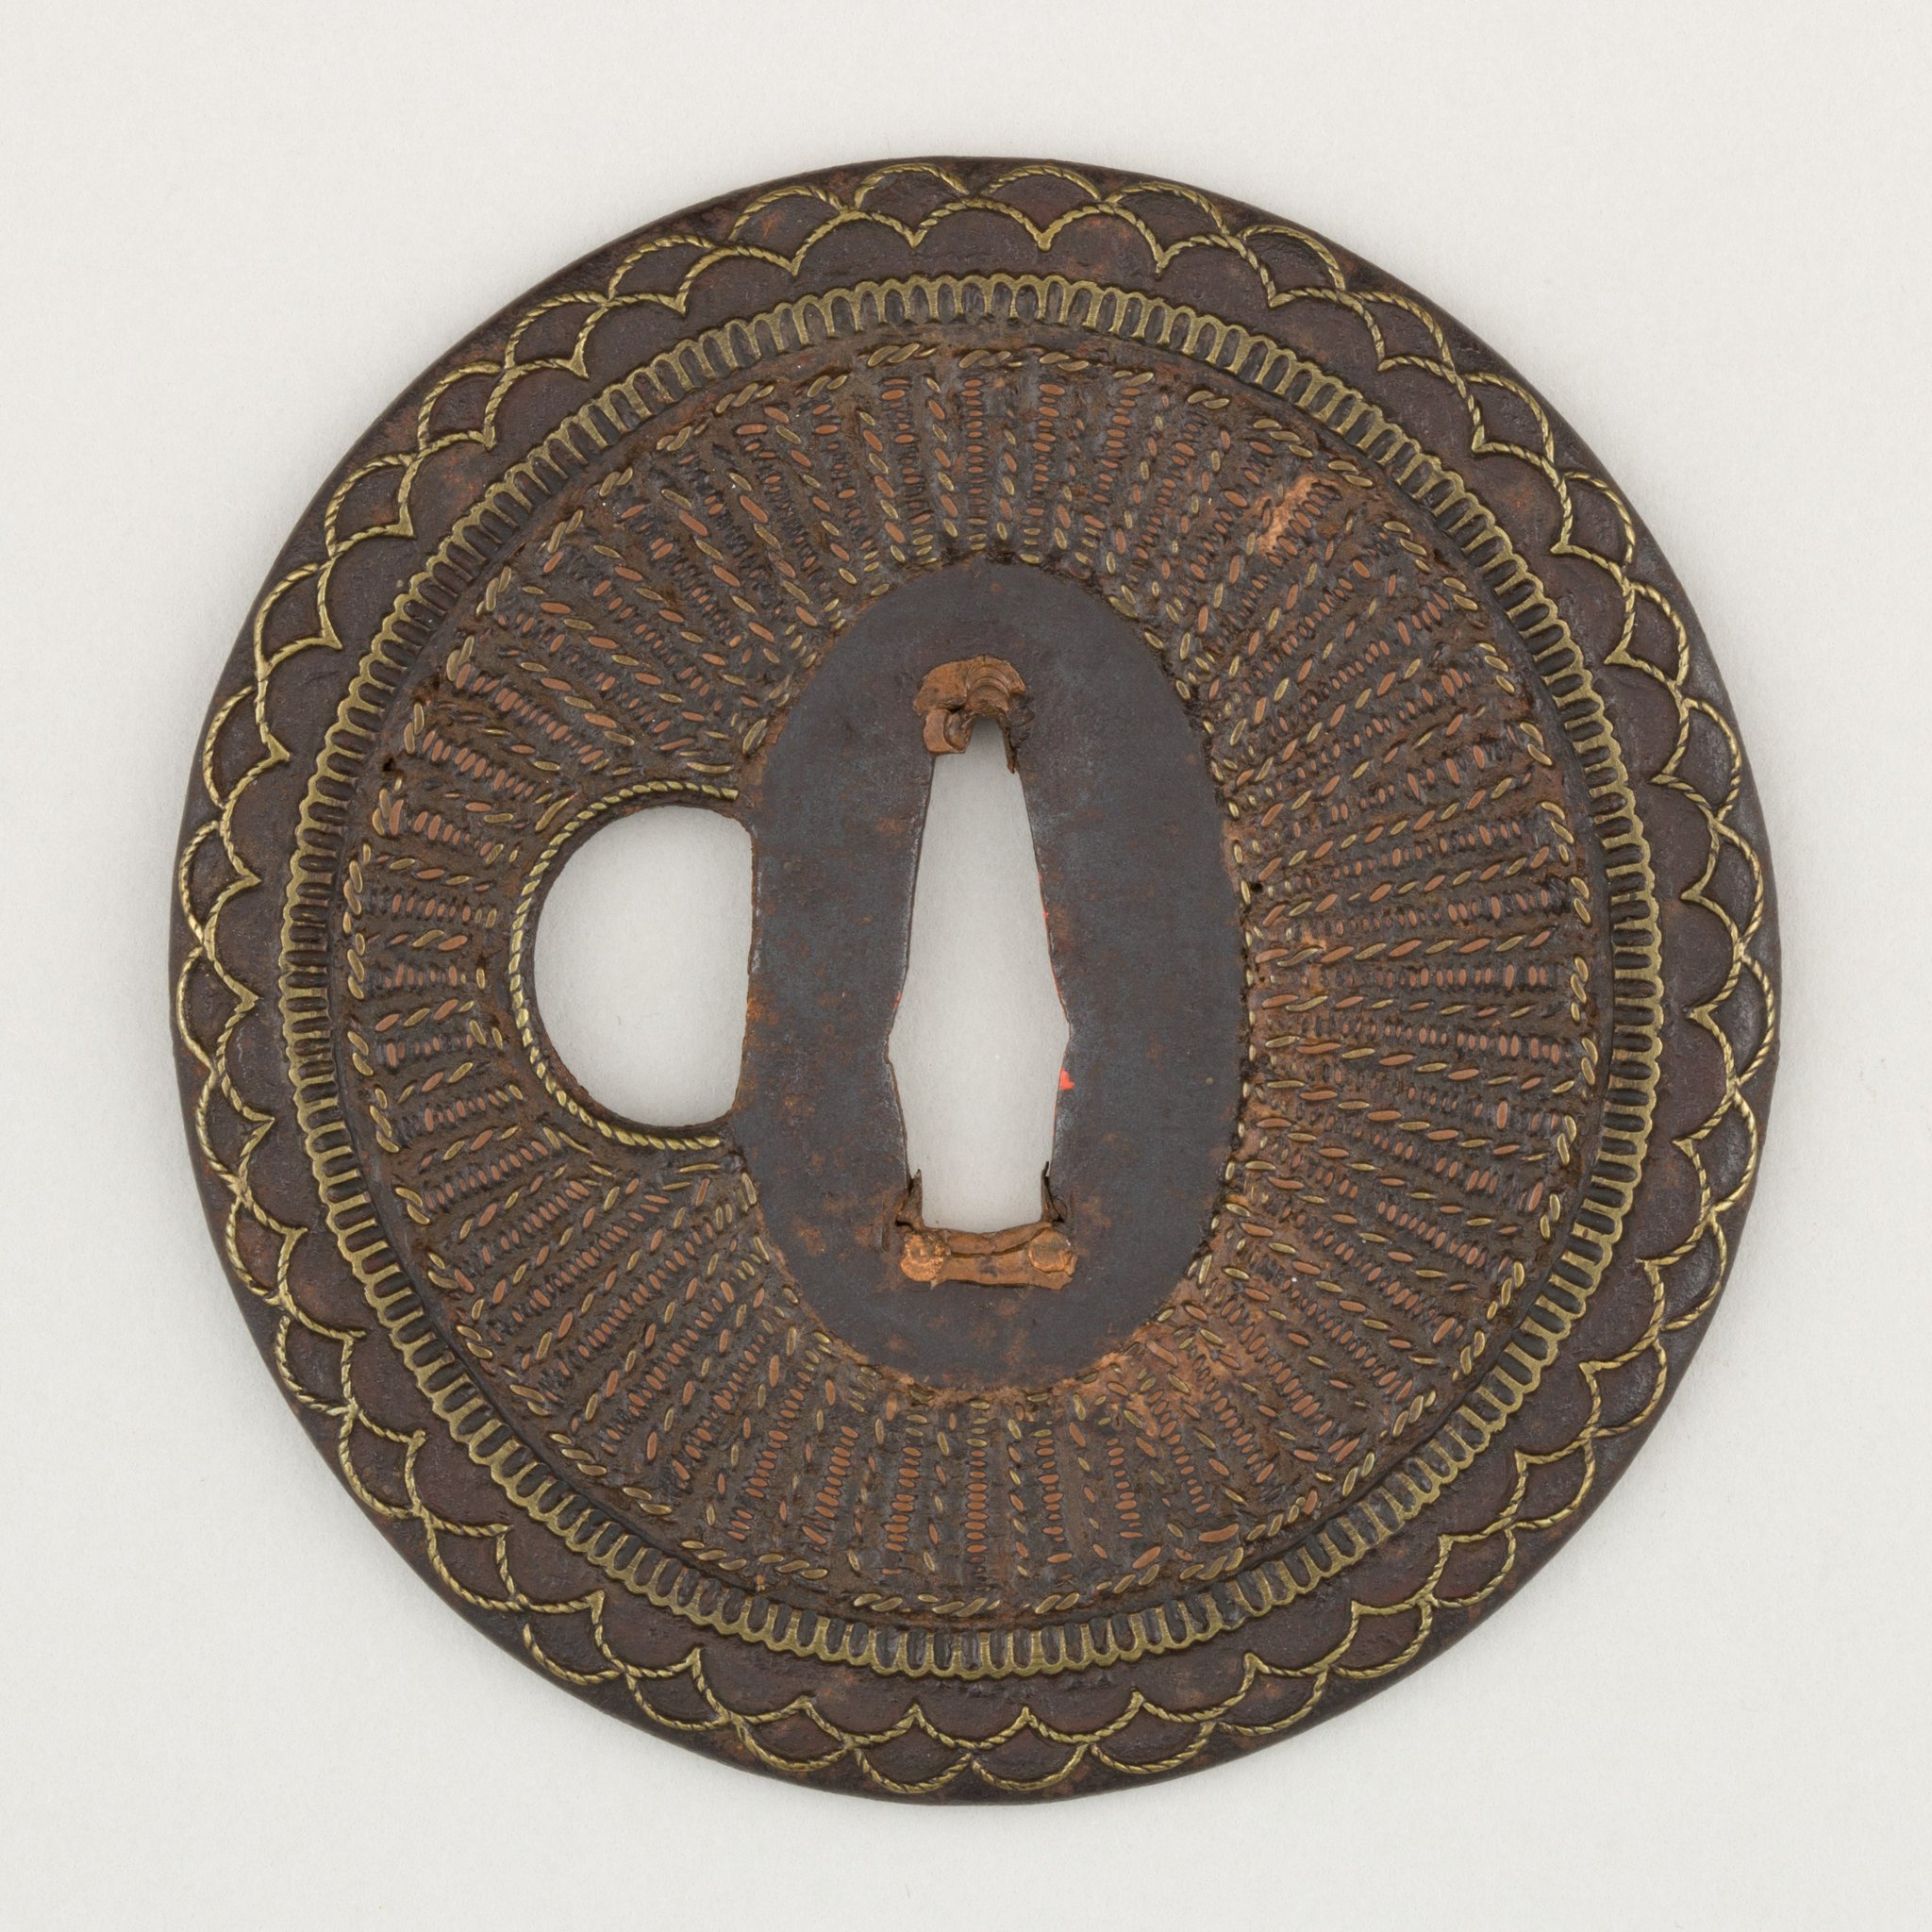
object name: sword guard tsuba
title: Sword Guard (Tsuba)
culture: japanese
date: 1700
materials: brass, copper, iron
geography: japan